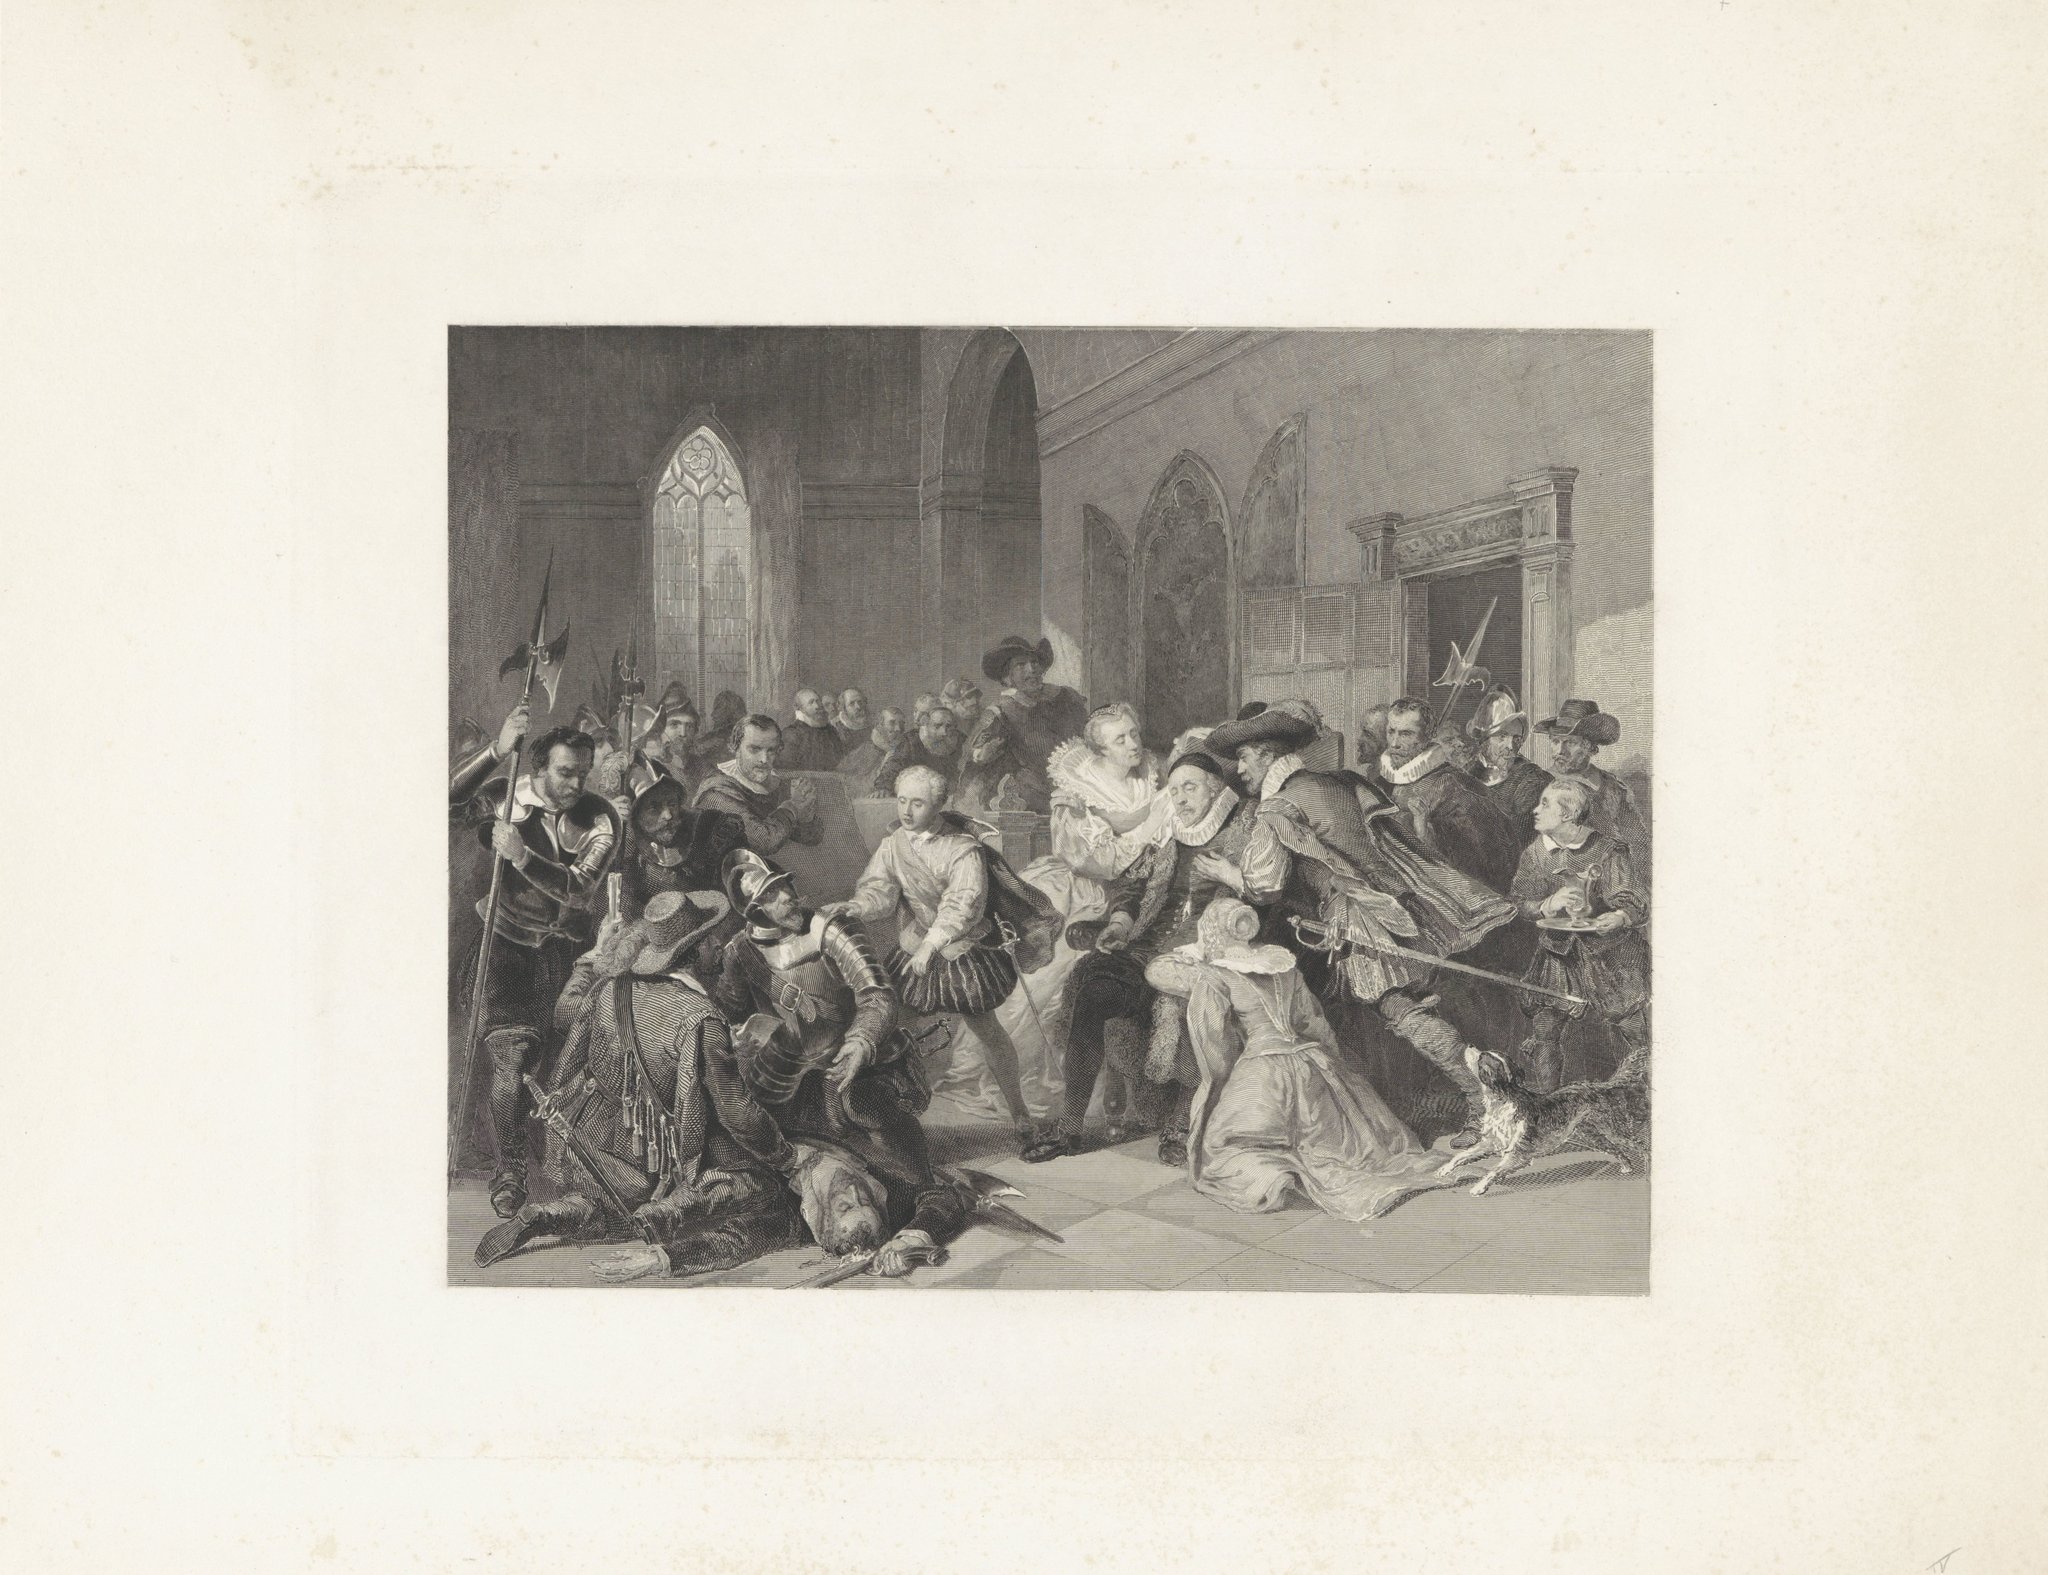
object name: print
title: Aanslag van Jean de Jauregui op prins Willem I, 18 maart 1582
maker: johann wilhelm kaiser (i)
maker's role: draughtsman, print maker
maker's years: 1813-1900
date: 1853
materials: paper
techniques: engraving, etching, roulette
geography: amsterdam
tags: antwerp, charlotte of bourbon, delft, william i (prince of orange), the hague, maurice (prince of orange)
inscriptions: collector's mark: Lugt 2228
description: Aanslag van Jean de Jauregui op prins Willem I, 18 maart 1582 te Antwerpen. Interieur met de prins die gewond in een stoel zit, met familie en anderen om zich heen. Links op de vloer ligt het lichaam van de gedode Jean de Jauregui. Maurits vraagt de soldaten hem te onderzoeken.